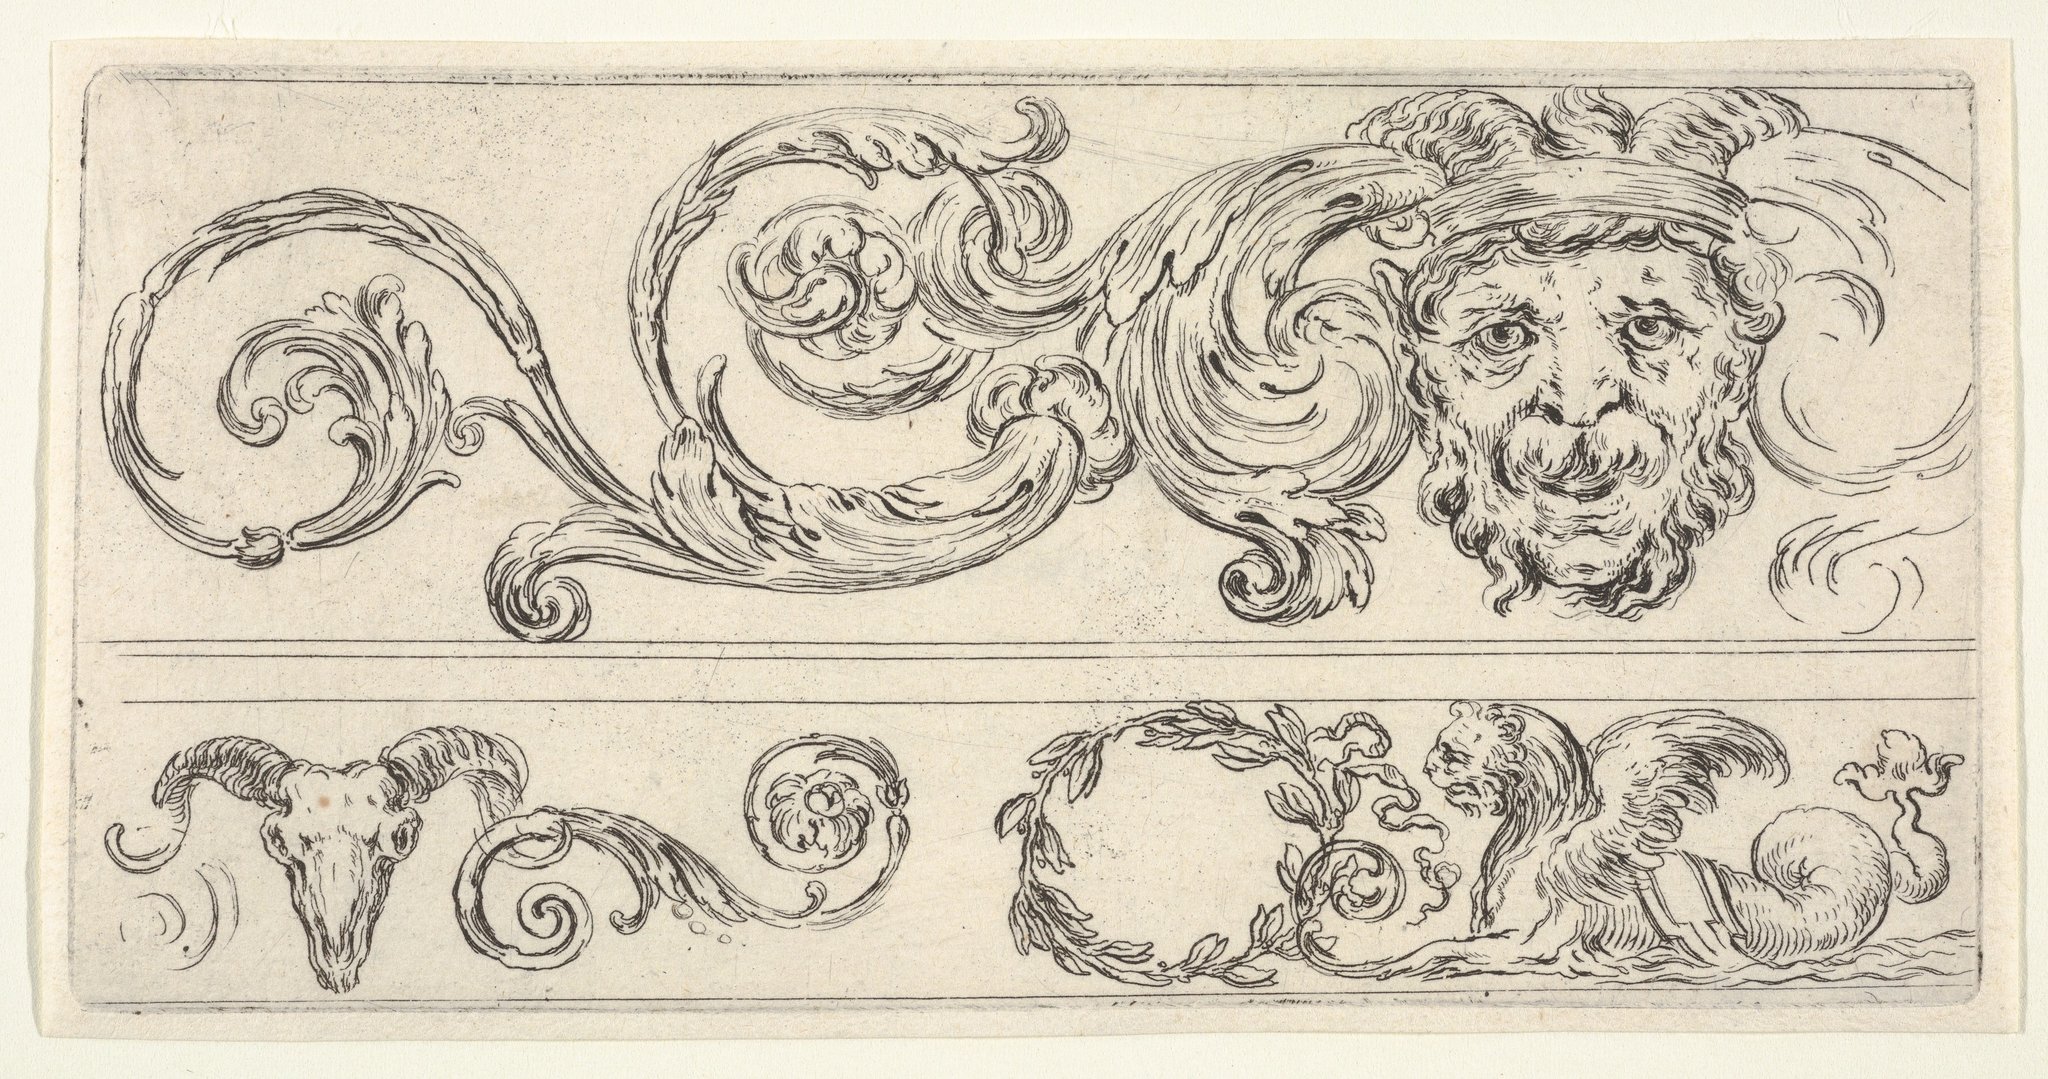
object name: print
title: Three fragments of friezes; on top, a grotesque head of a man, a skull of a ram at bottom left and a chimera at bottom right, plate 2 from "Friezes, foliage, and grotesques" (Frises, feuillages et grotesques)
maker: stefano della bella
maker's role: artist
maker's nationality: italian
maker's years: 1610-1664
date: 1638-1643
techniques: etching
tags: ornament,heads,mythical creatures